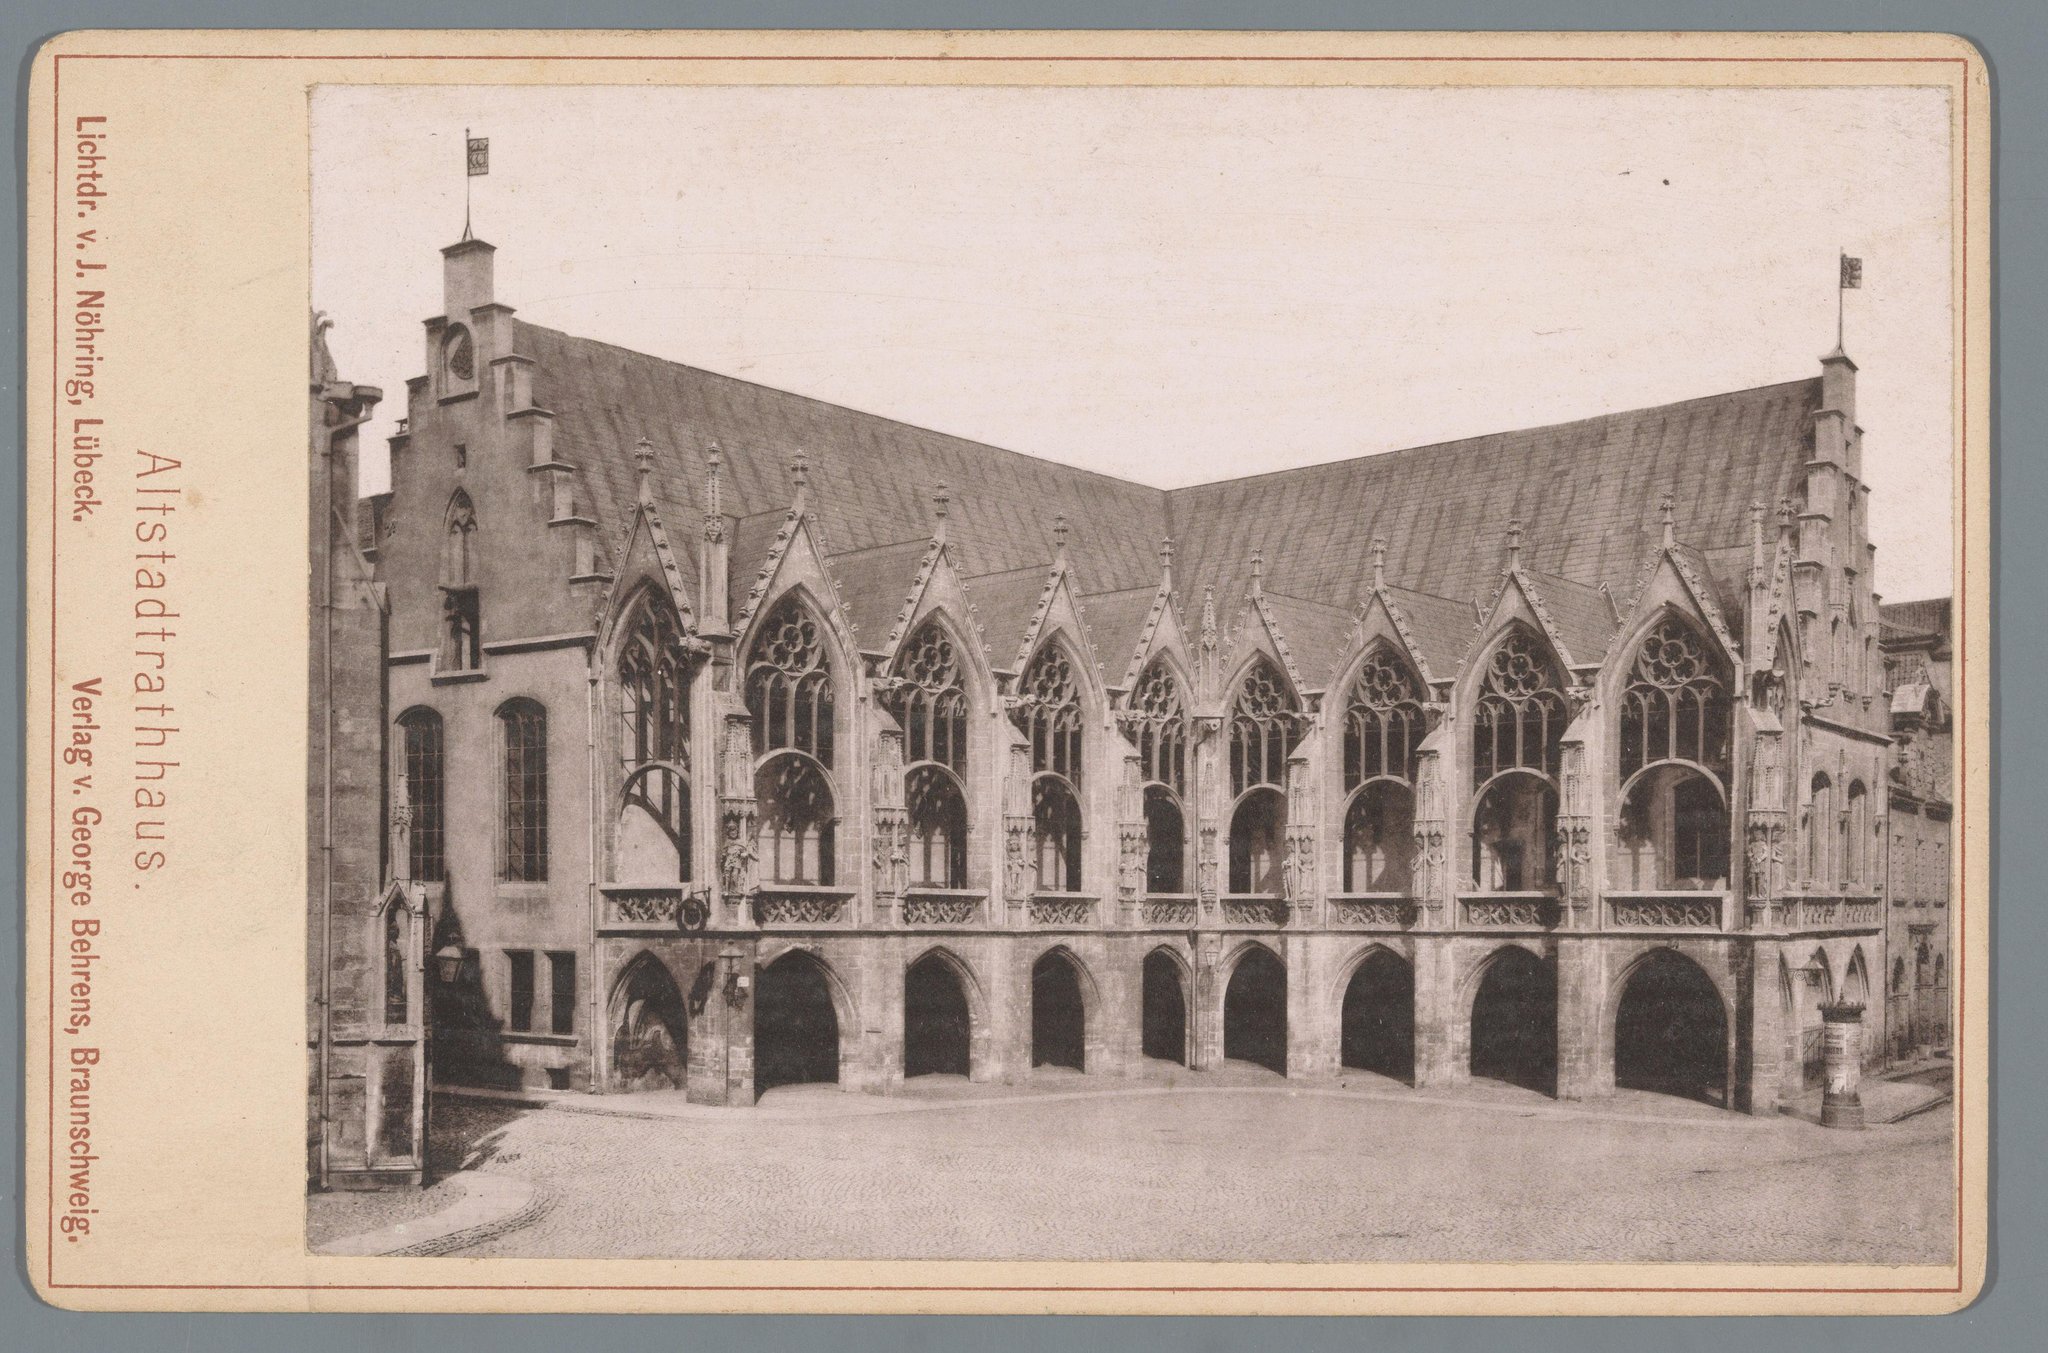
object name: photomechanical print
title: Altstadrathhaus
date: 1880-1900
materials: cardboard, paper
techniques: photograph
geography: lübeck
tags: townhall, façade (of house or building)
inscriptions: annotation: ‘Brunswijk’, retailer's mark: ‘George Behrens, Verlags-Kunsthandlung, Bilder-, Spiegel-, Rahmen-u. Goldleisten-Fabrik,/ Braunschweig/ Friedrich-Wilhelmstr. No.10/ (...)’